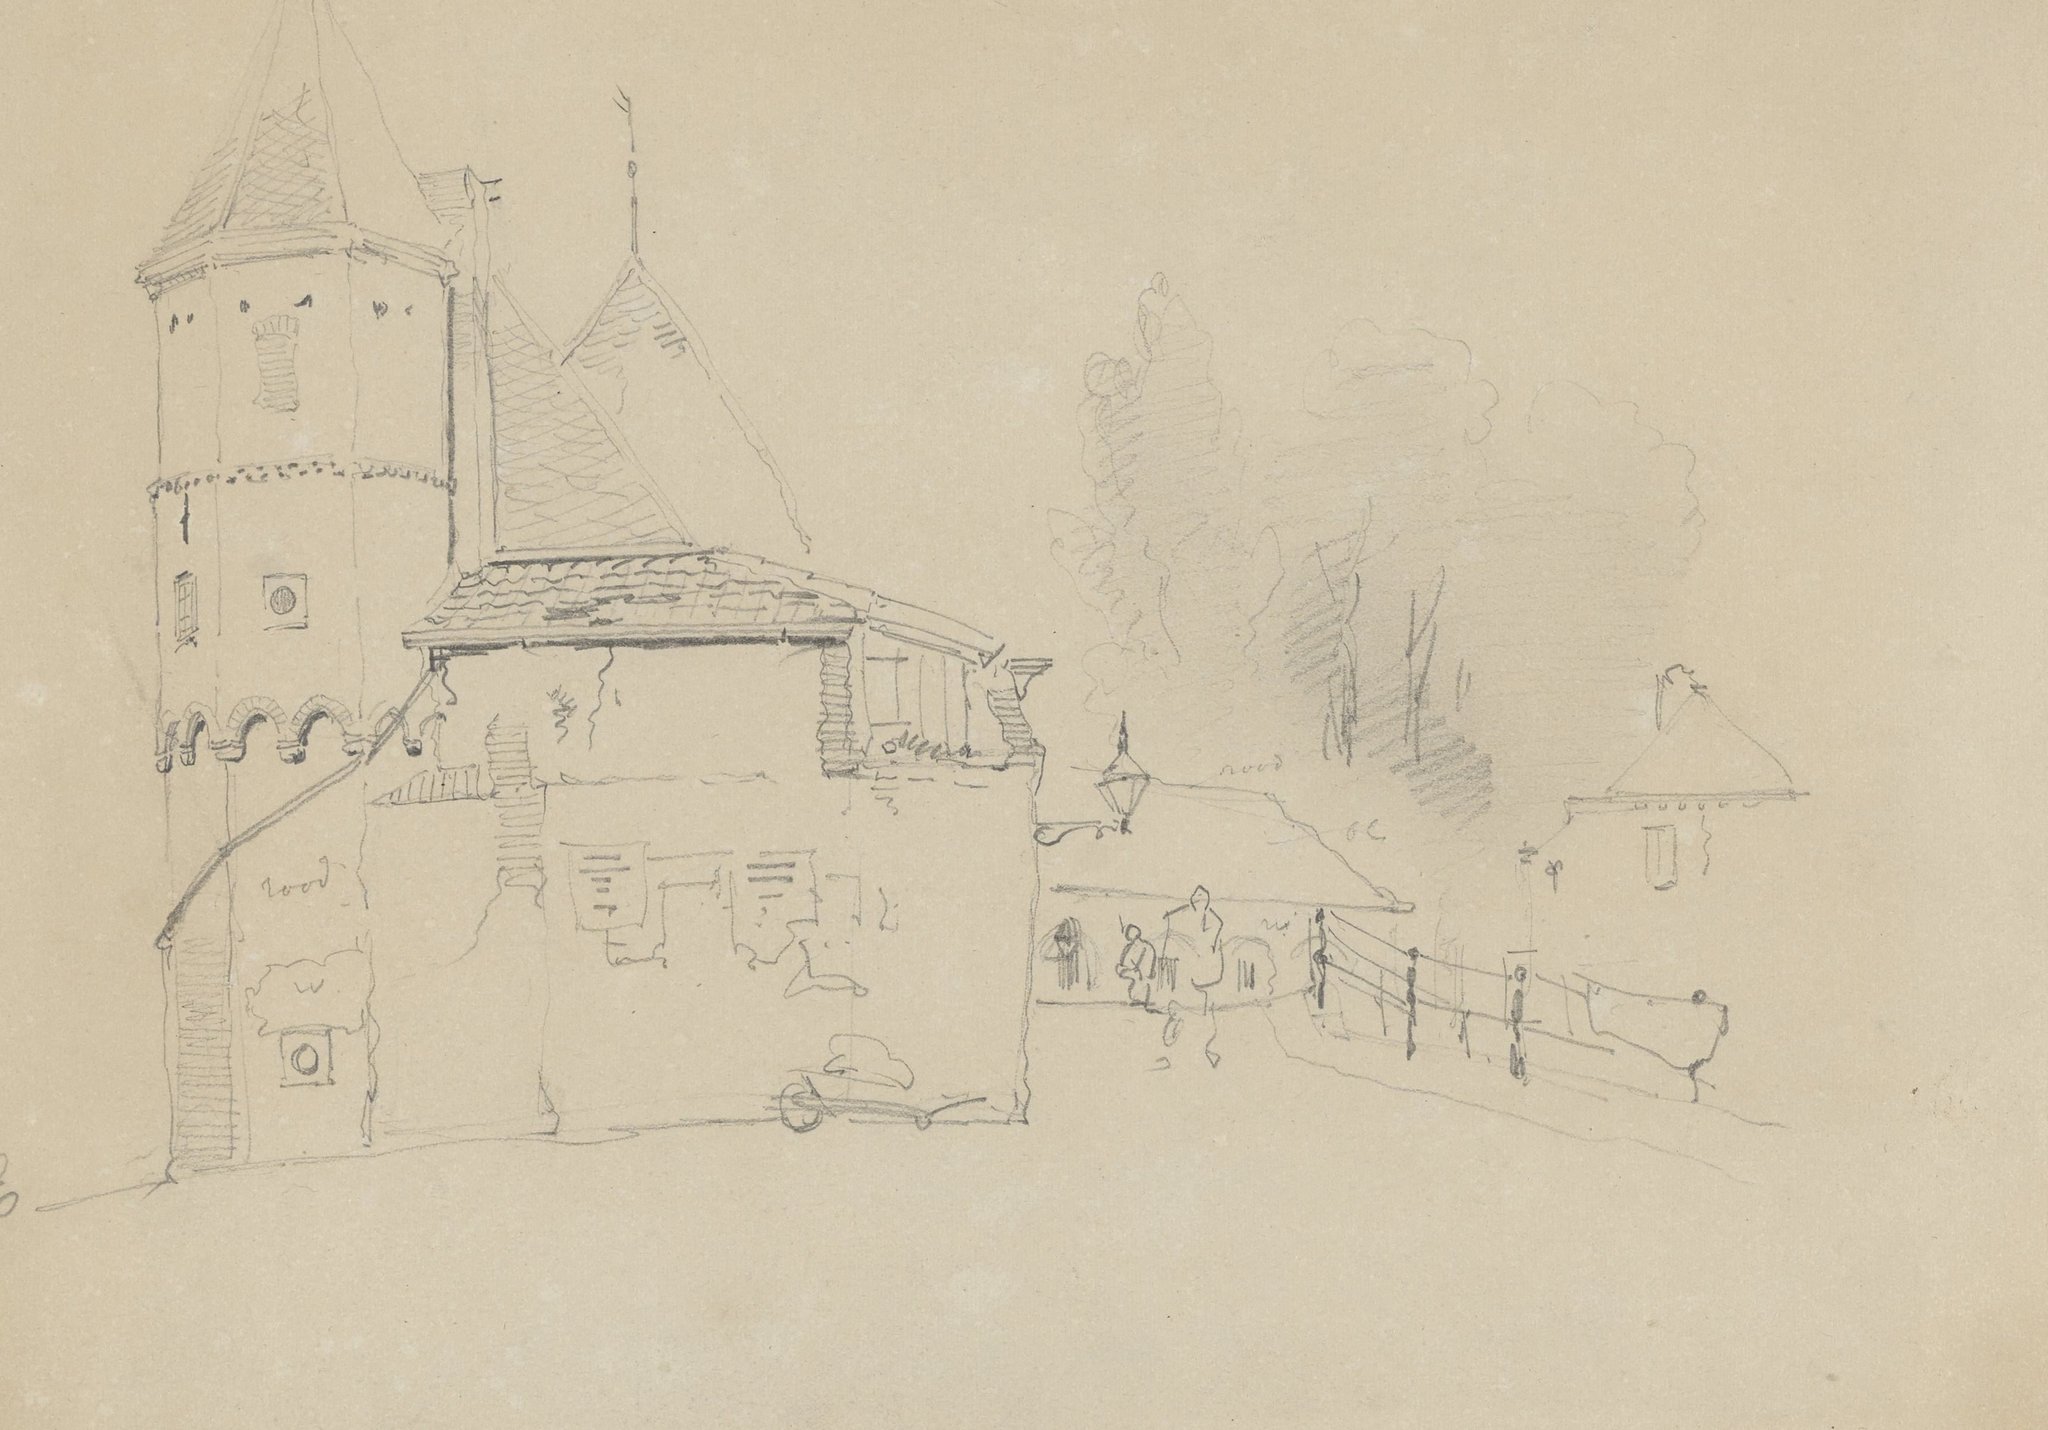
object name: drawing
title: Gezicht op de Koppelpoort te Amersfoort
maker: adrianus eversen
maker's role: draughtsman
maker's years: 1818-1897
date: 1828-1897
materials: paper, pencil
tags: koppelpoort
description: Gezicht op de Koppelpoort te Amersfoort, met enkele kleurnotities.